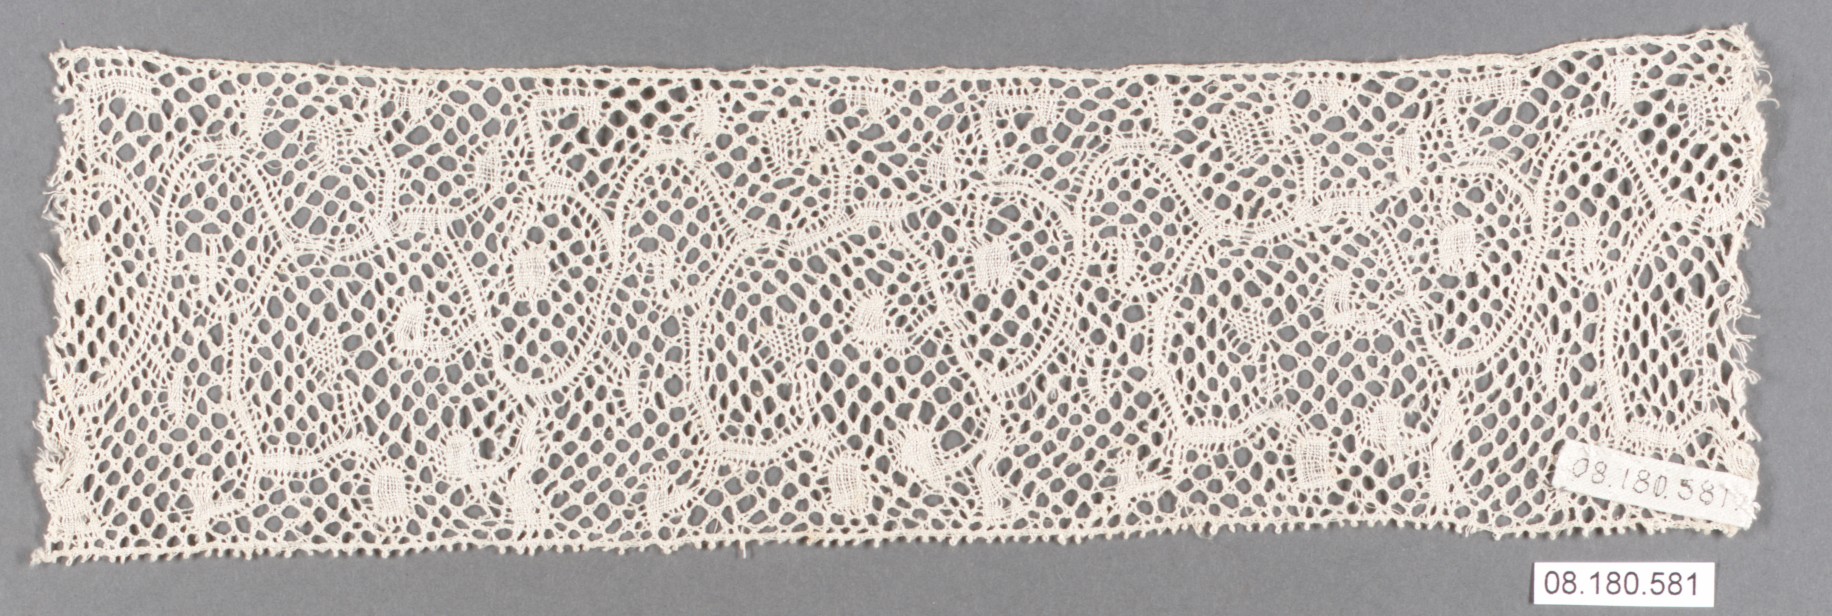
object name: piece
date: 1801-1900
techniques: lace